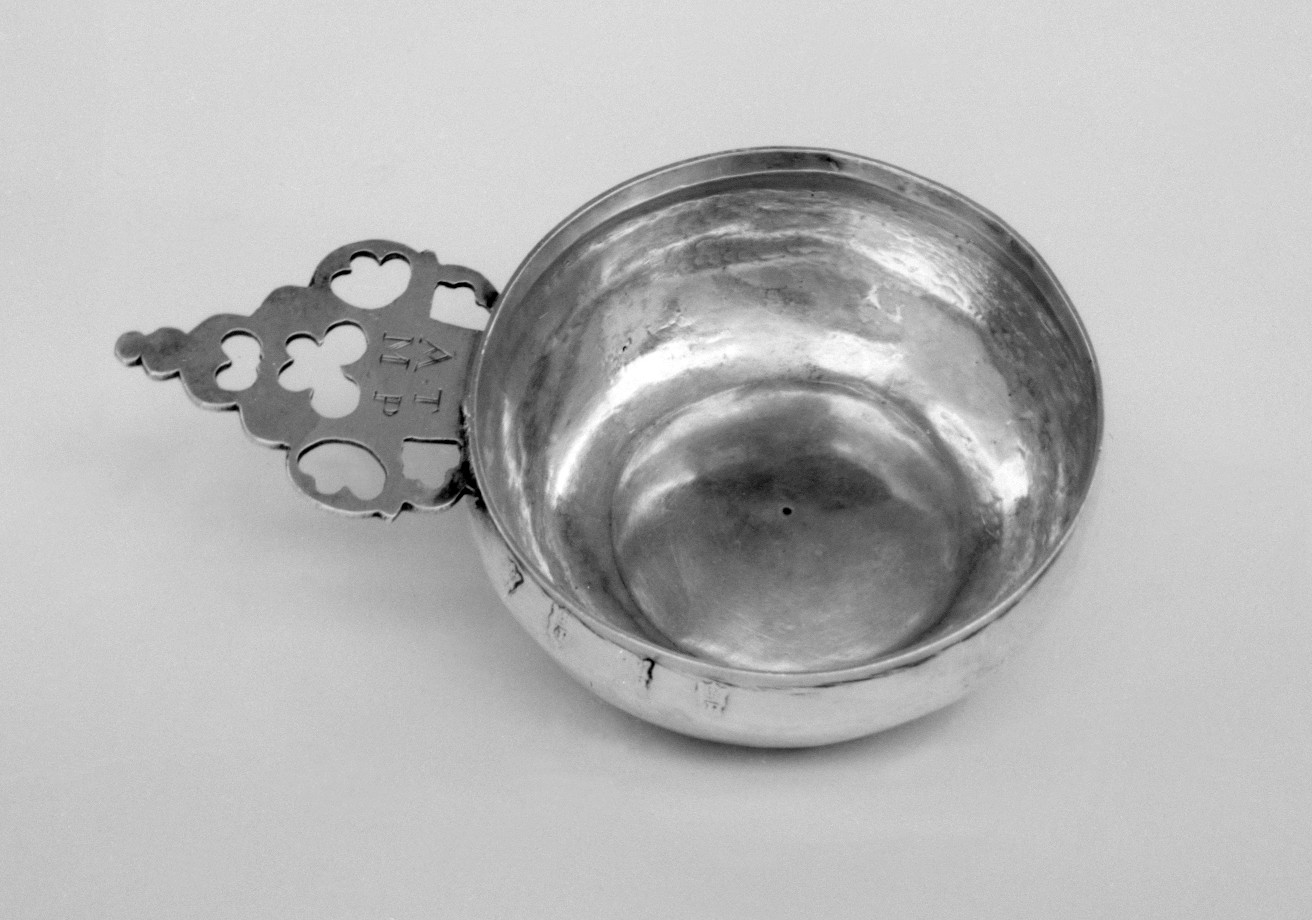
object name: porringer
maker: john bradley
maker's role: maker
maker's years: 1694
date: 1667-1733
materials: silver